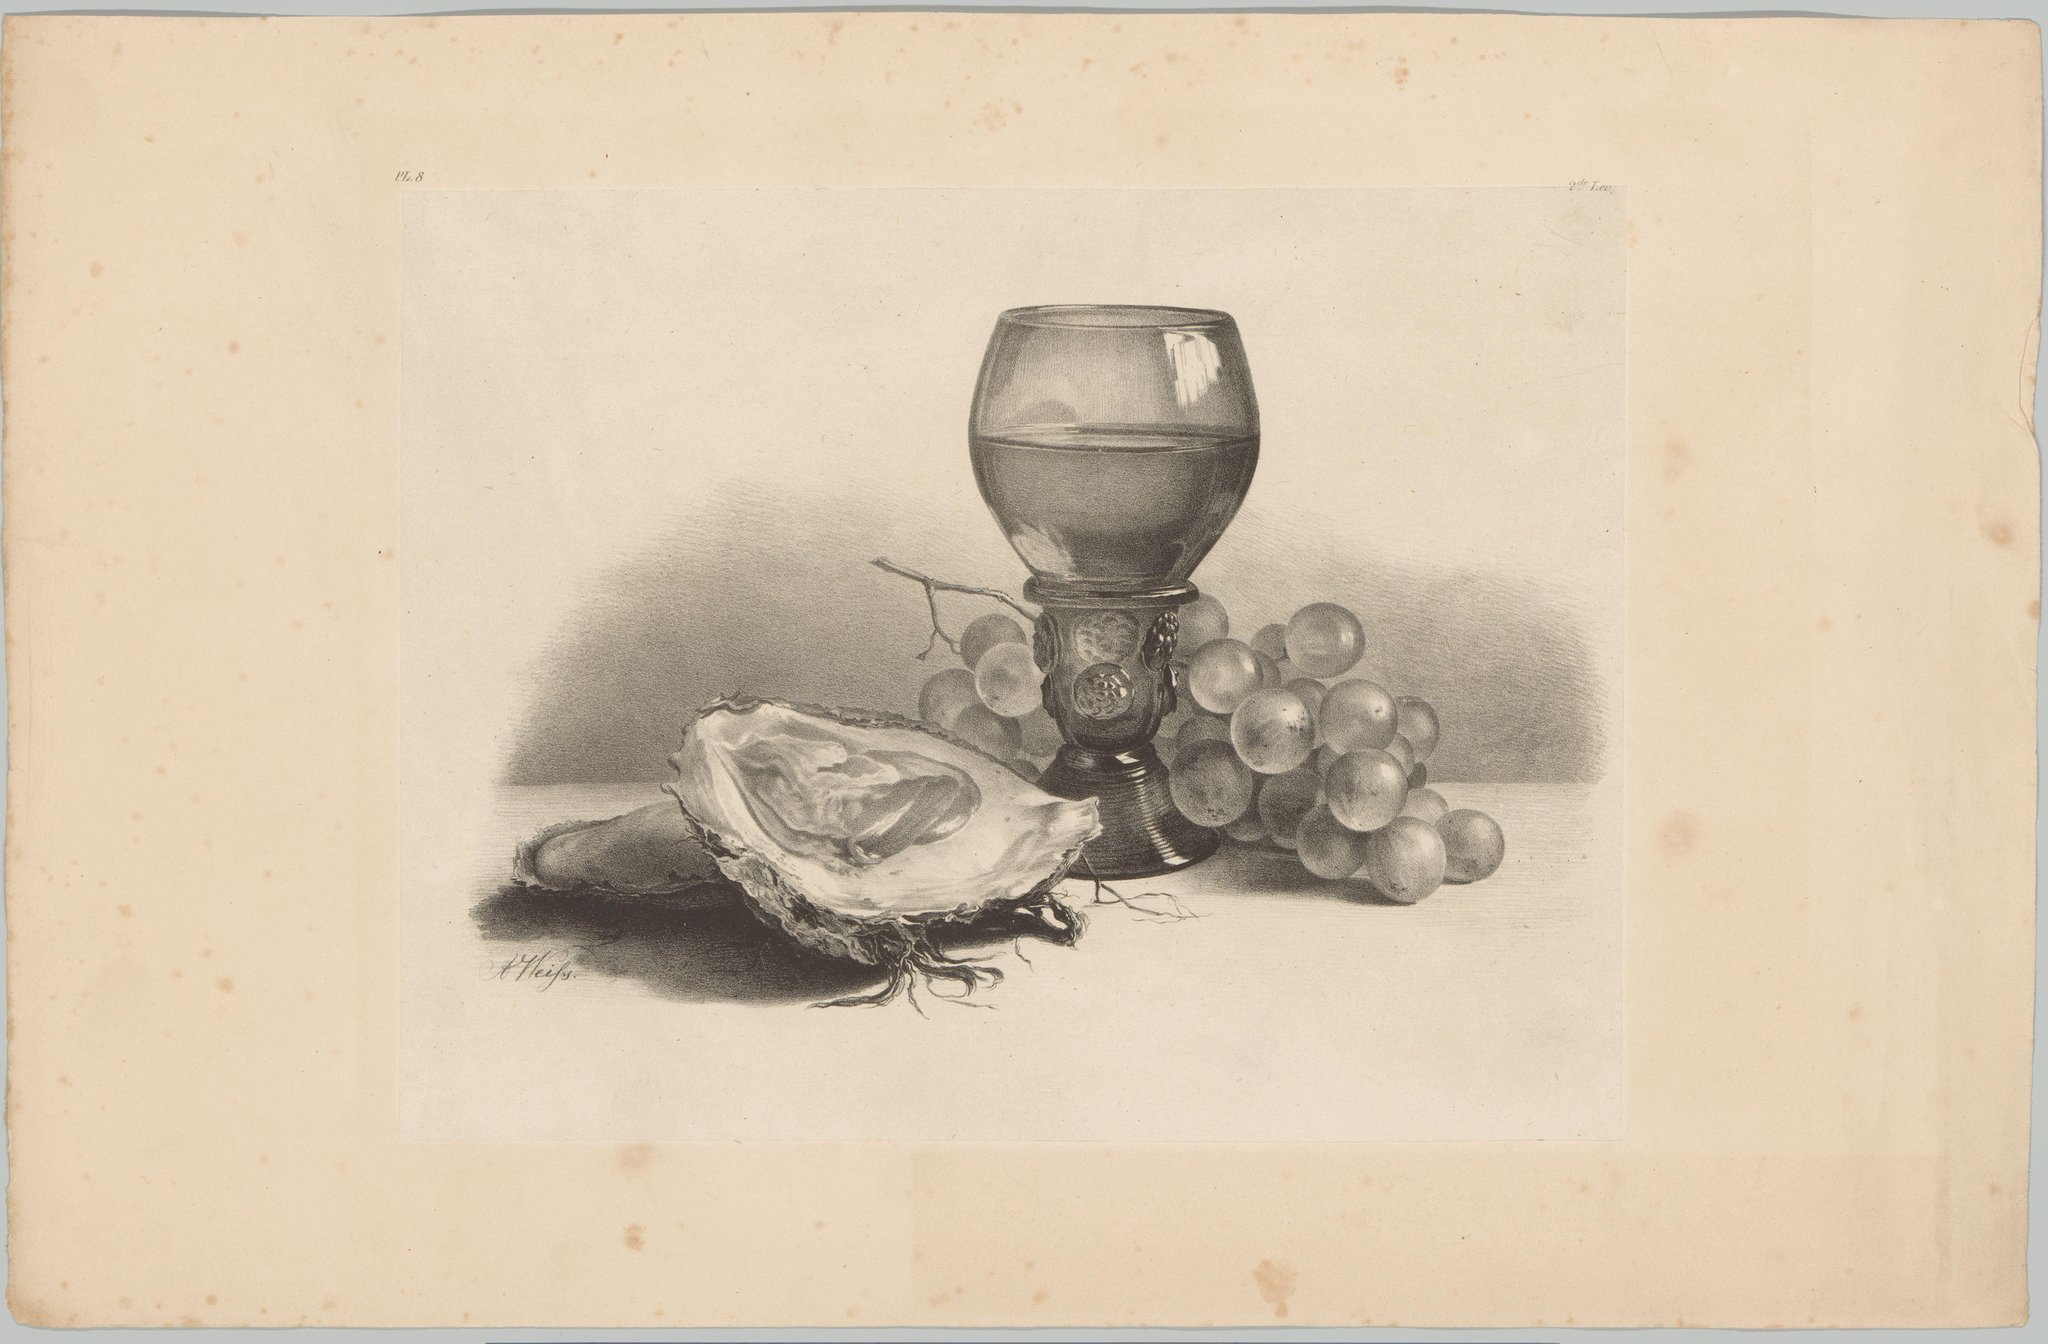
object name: print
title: Stilleven met glas, oesters en druiven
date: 1820-1833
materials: paper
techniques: lithograph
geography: amsterdam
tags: molluscs: oyster, fruits, foodstuffs; still life of foodstuffs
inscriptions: collector's mark: Lugt 2228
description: Rechts boven genummerd 2de Lev. Onderdeel van een omslag met in totaal zevenenzeventig lithografieën van bloemen en fruit.